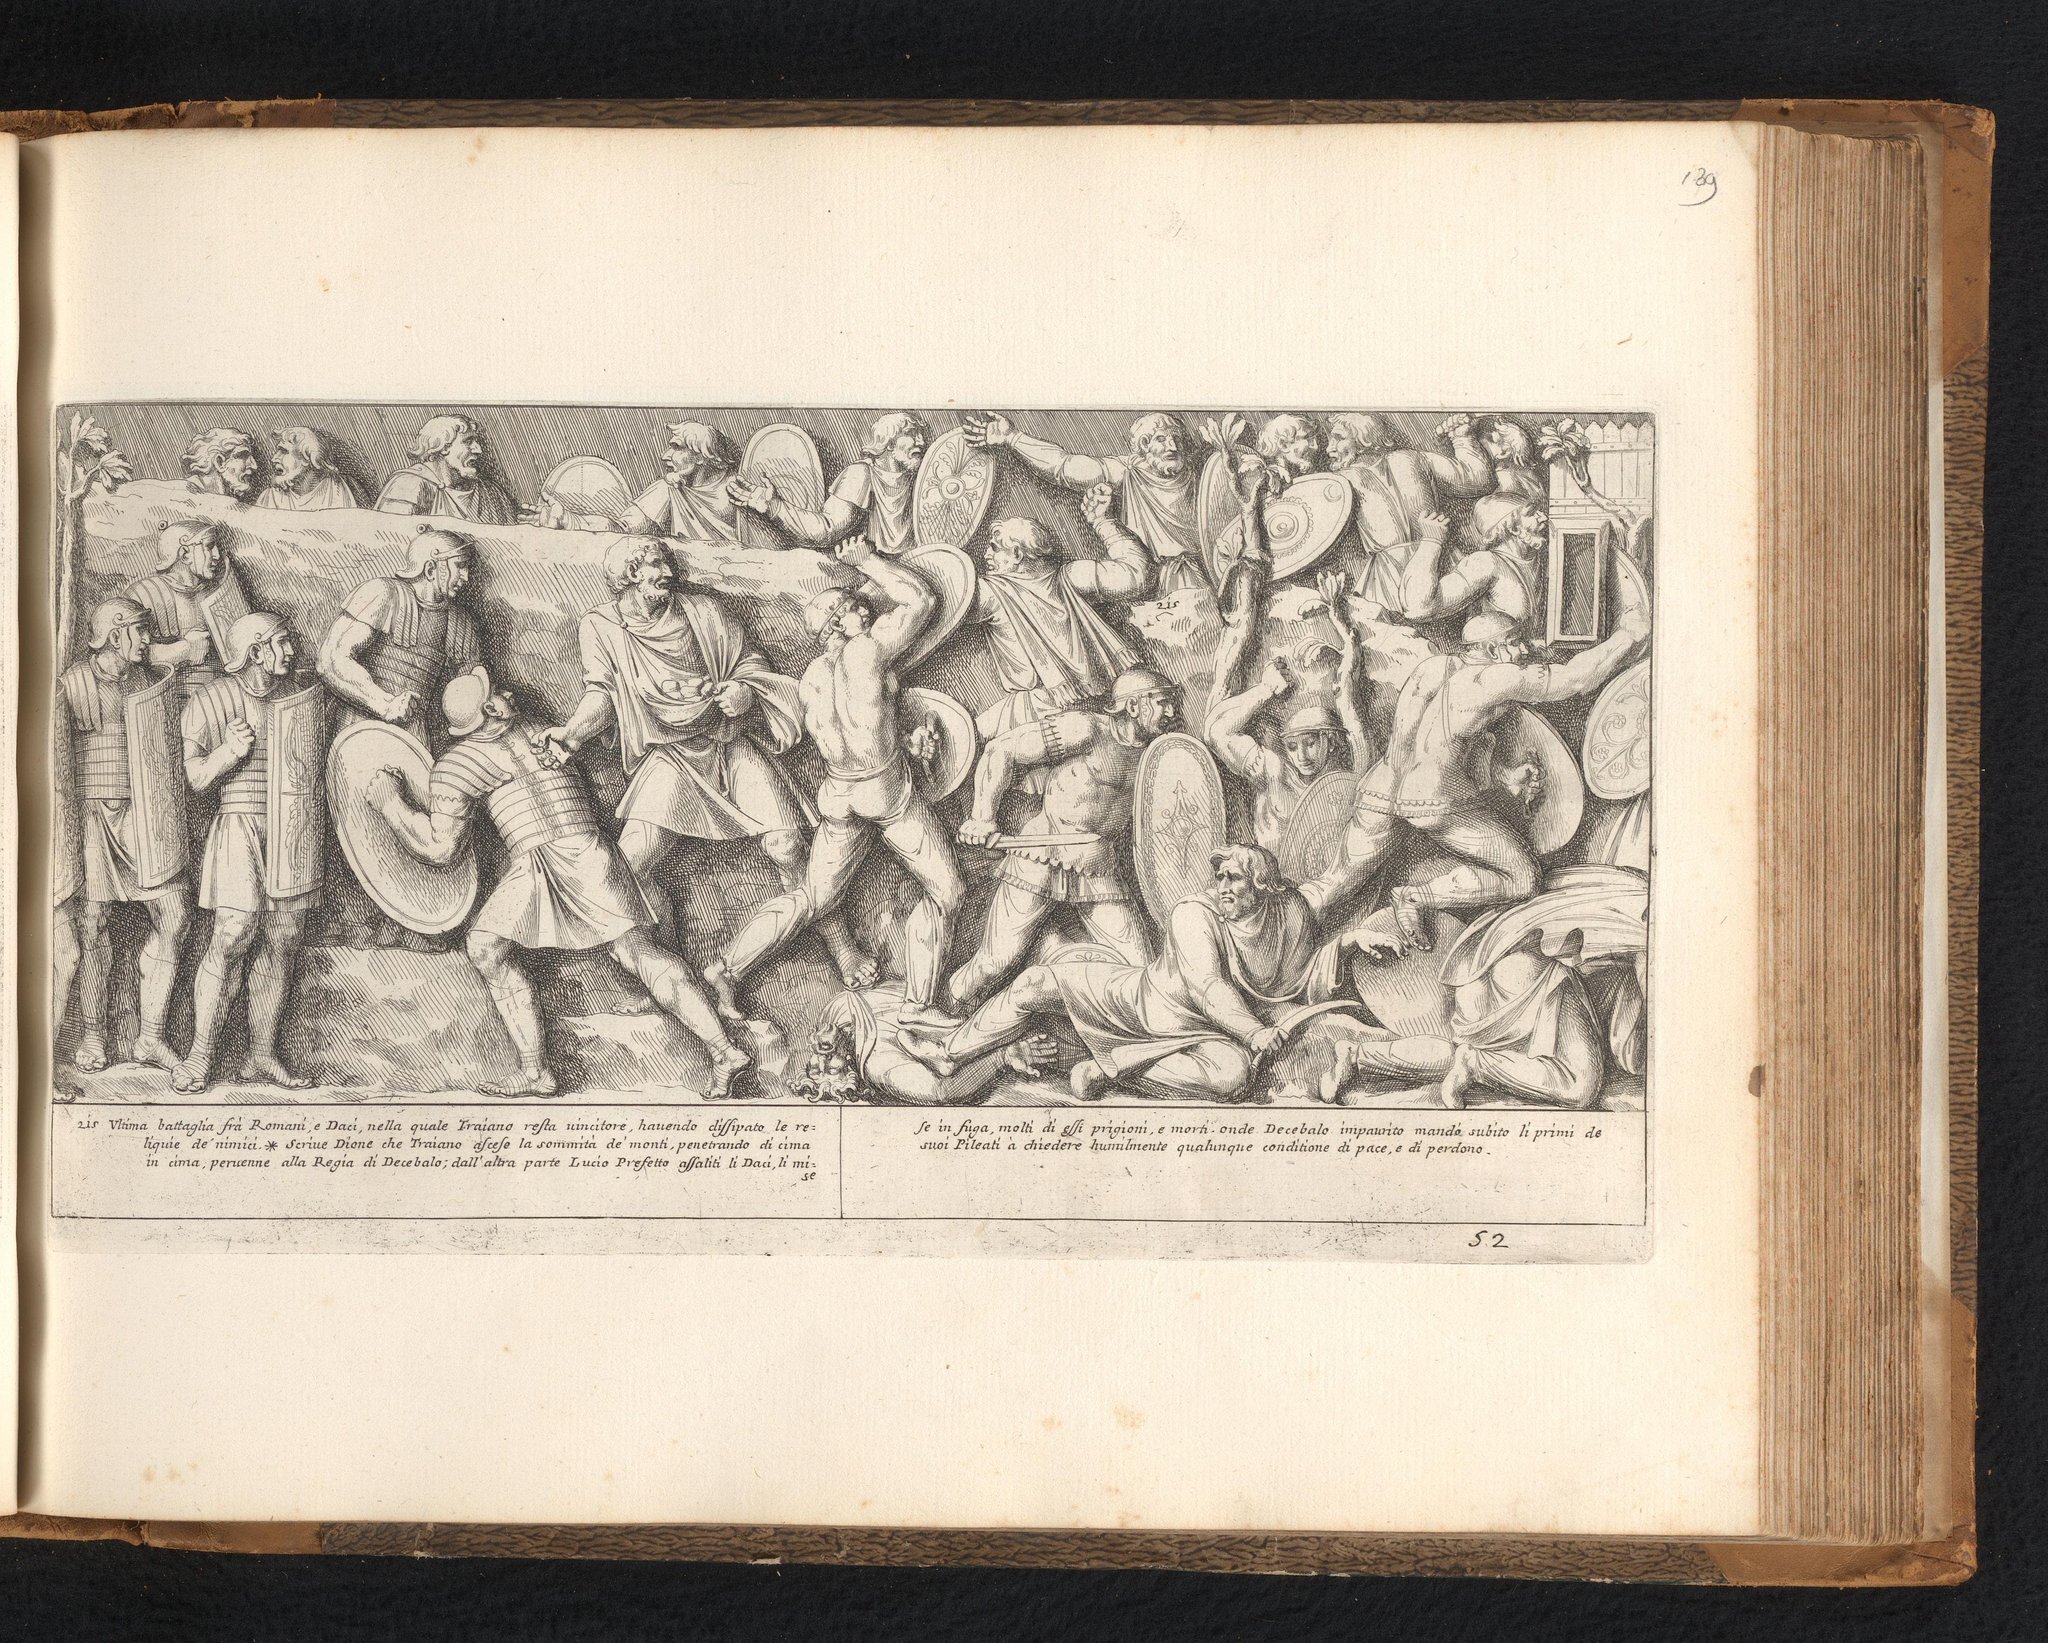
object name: album leaf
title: Detail van het fries op de Zuil van Trajanus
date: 1637-1691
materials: paper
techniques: etching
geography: rome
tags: triumphal column with helical friezes, piece of sculpture, reproduction of a piece of sculpture, the soldier; the soldier's life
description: Detail van het spiraalvormige gebeeldhouwde fries op de Zuil van Trajanus. Het fries toont de oorlogen tussen de Romeinen en de Daciërs. Verklarende nummers in de ondermarge. Prent maakt deel uit van een album.